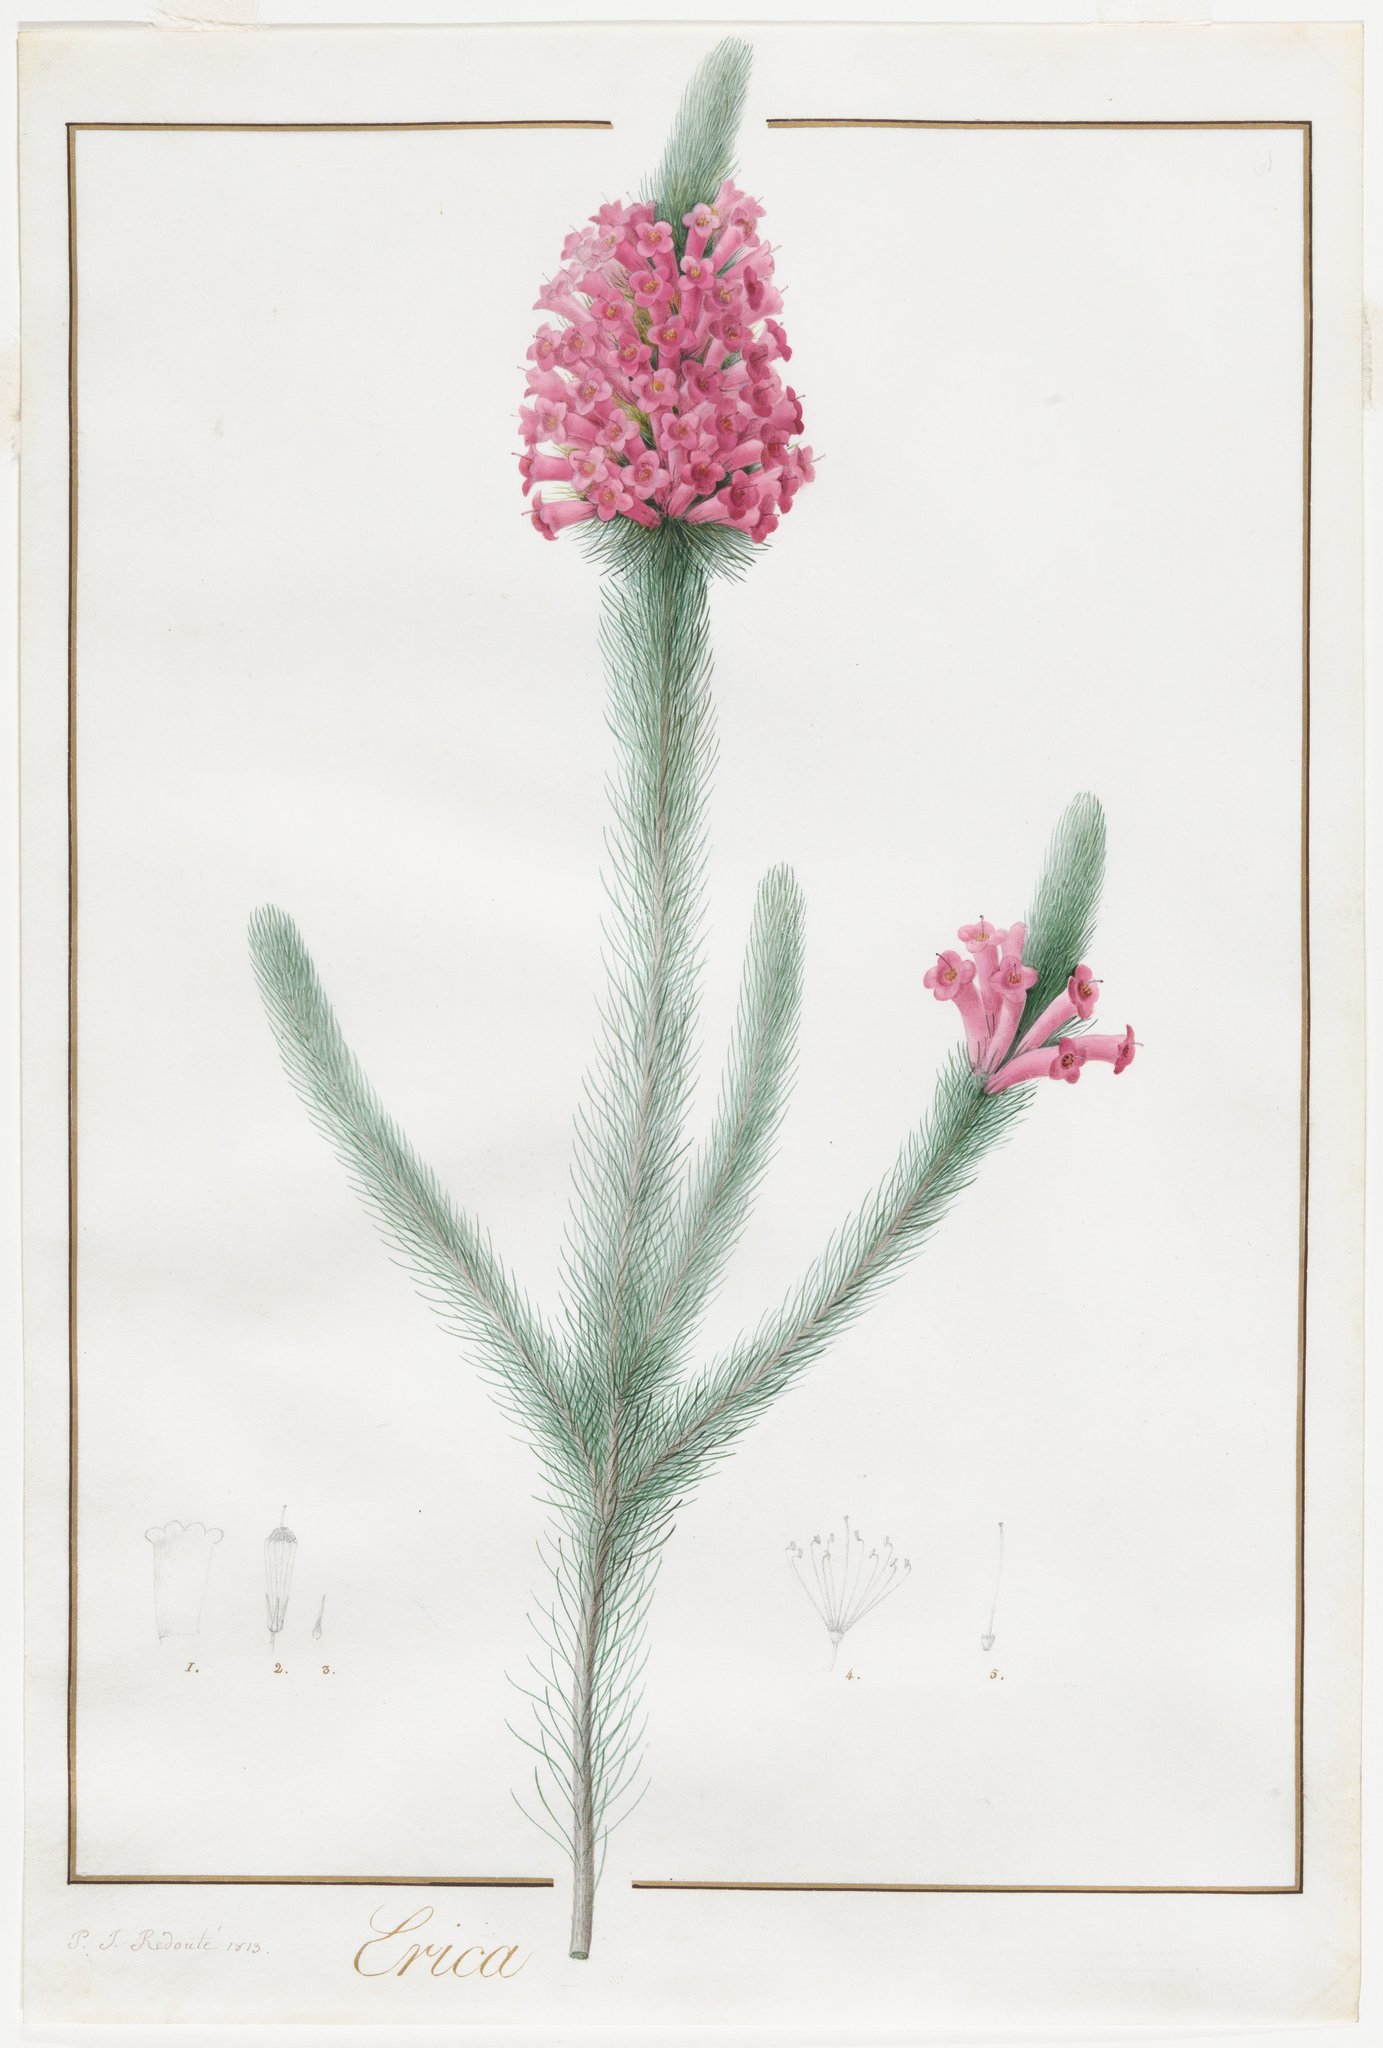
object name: drawing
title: Erica Fulgida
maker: pierre joseph redouté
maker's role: artist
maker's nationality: french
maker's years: 1759-1840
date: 1813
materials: graphite, parchment, watercolor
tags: plants